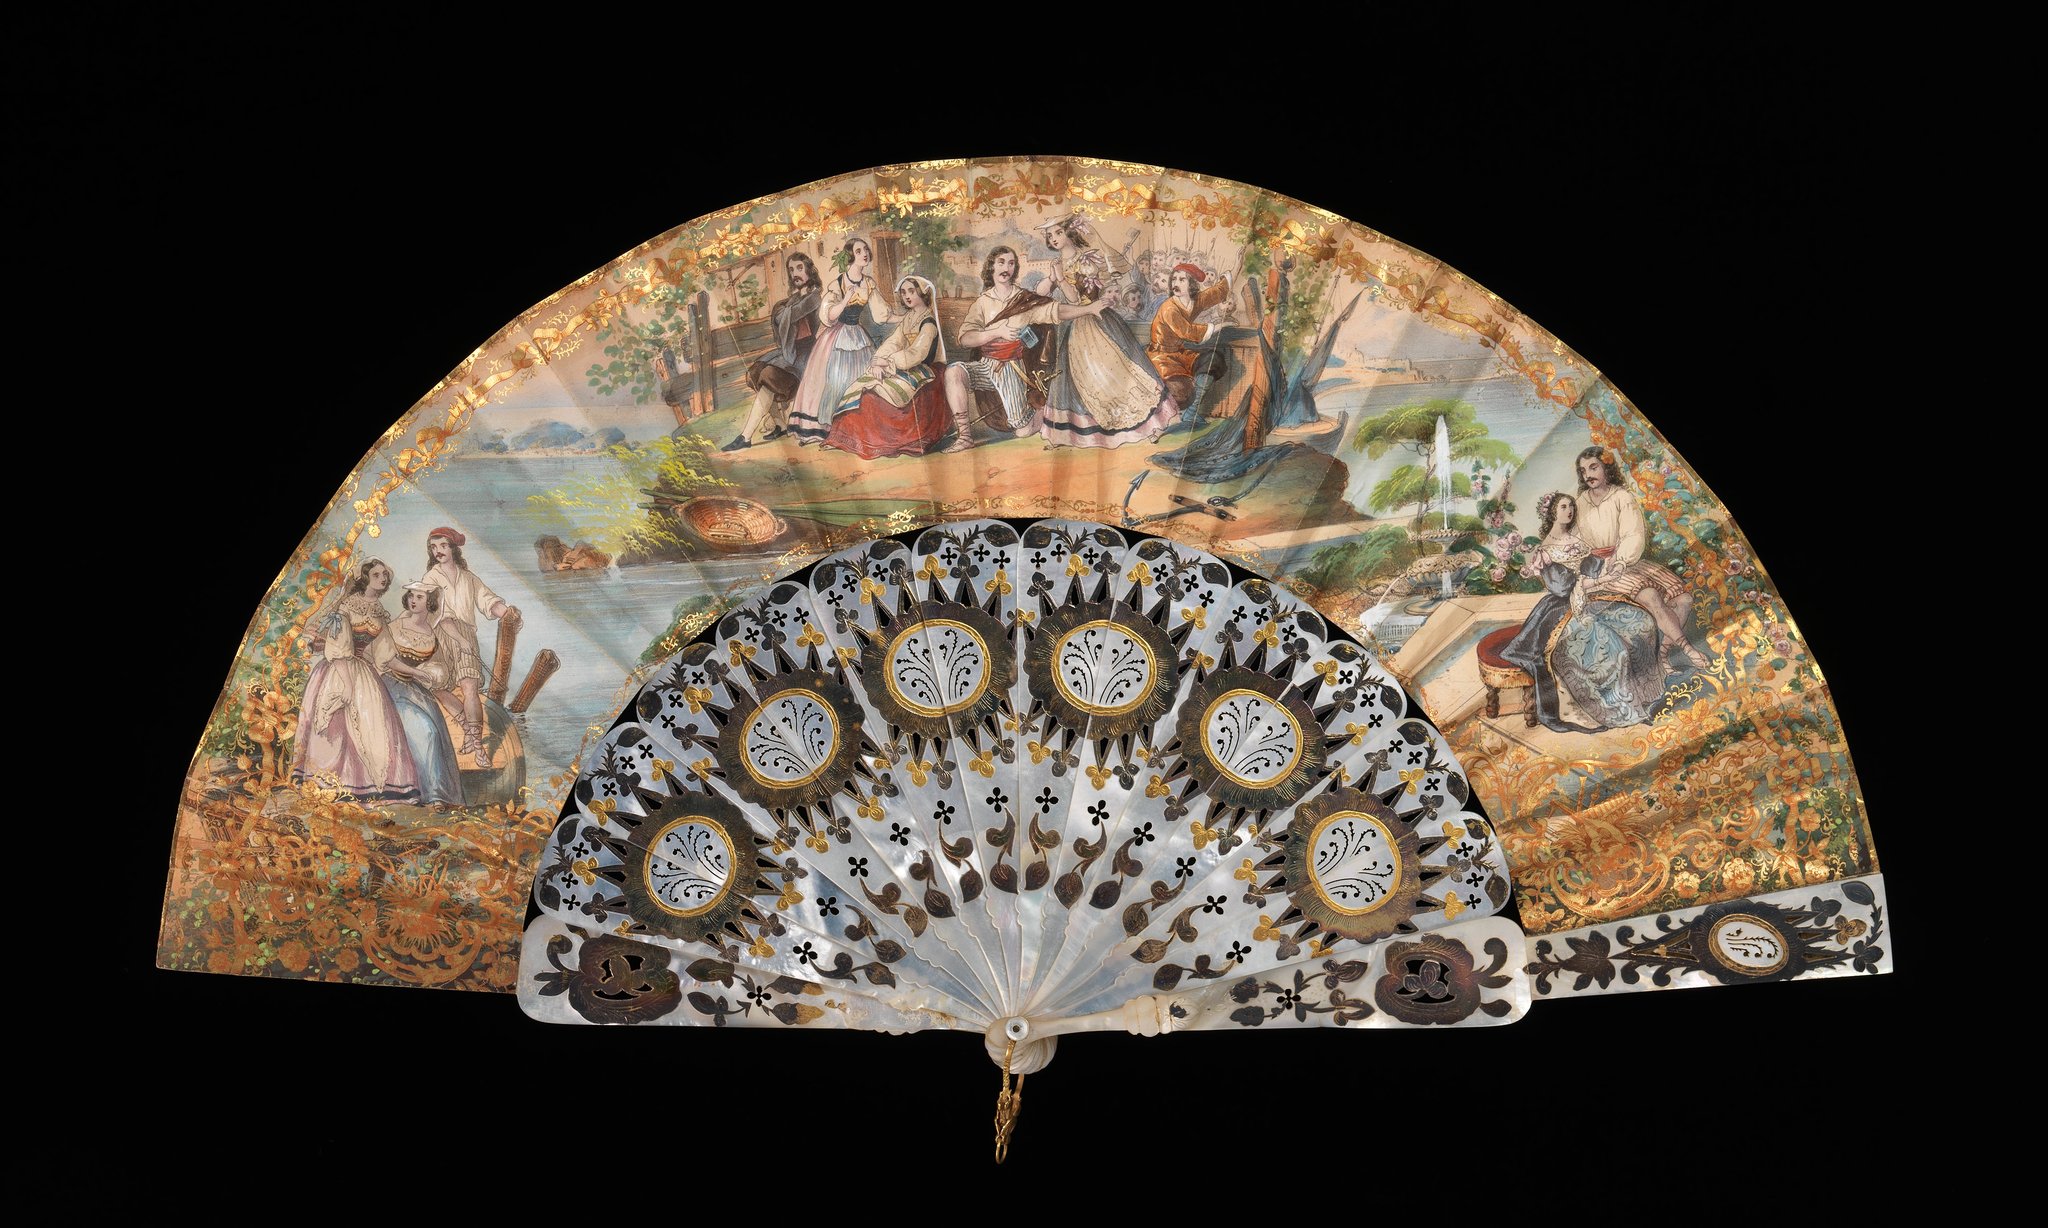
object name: fan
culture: european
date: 1855-1865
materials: metal, mother of pearl, paper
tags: men,women